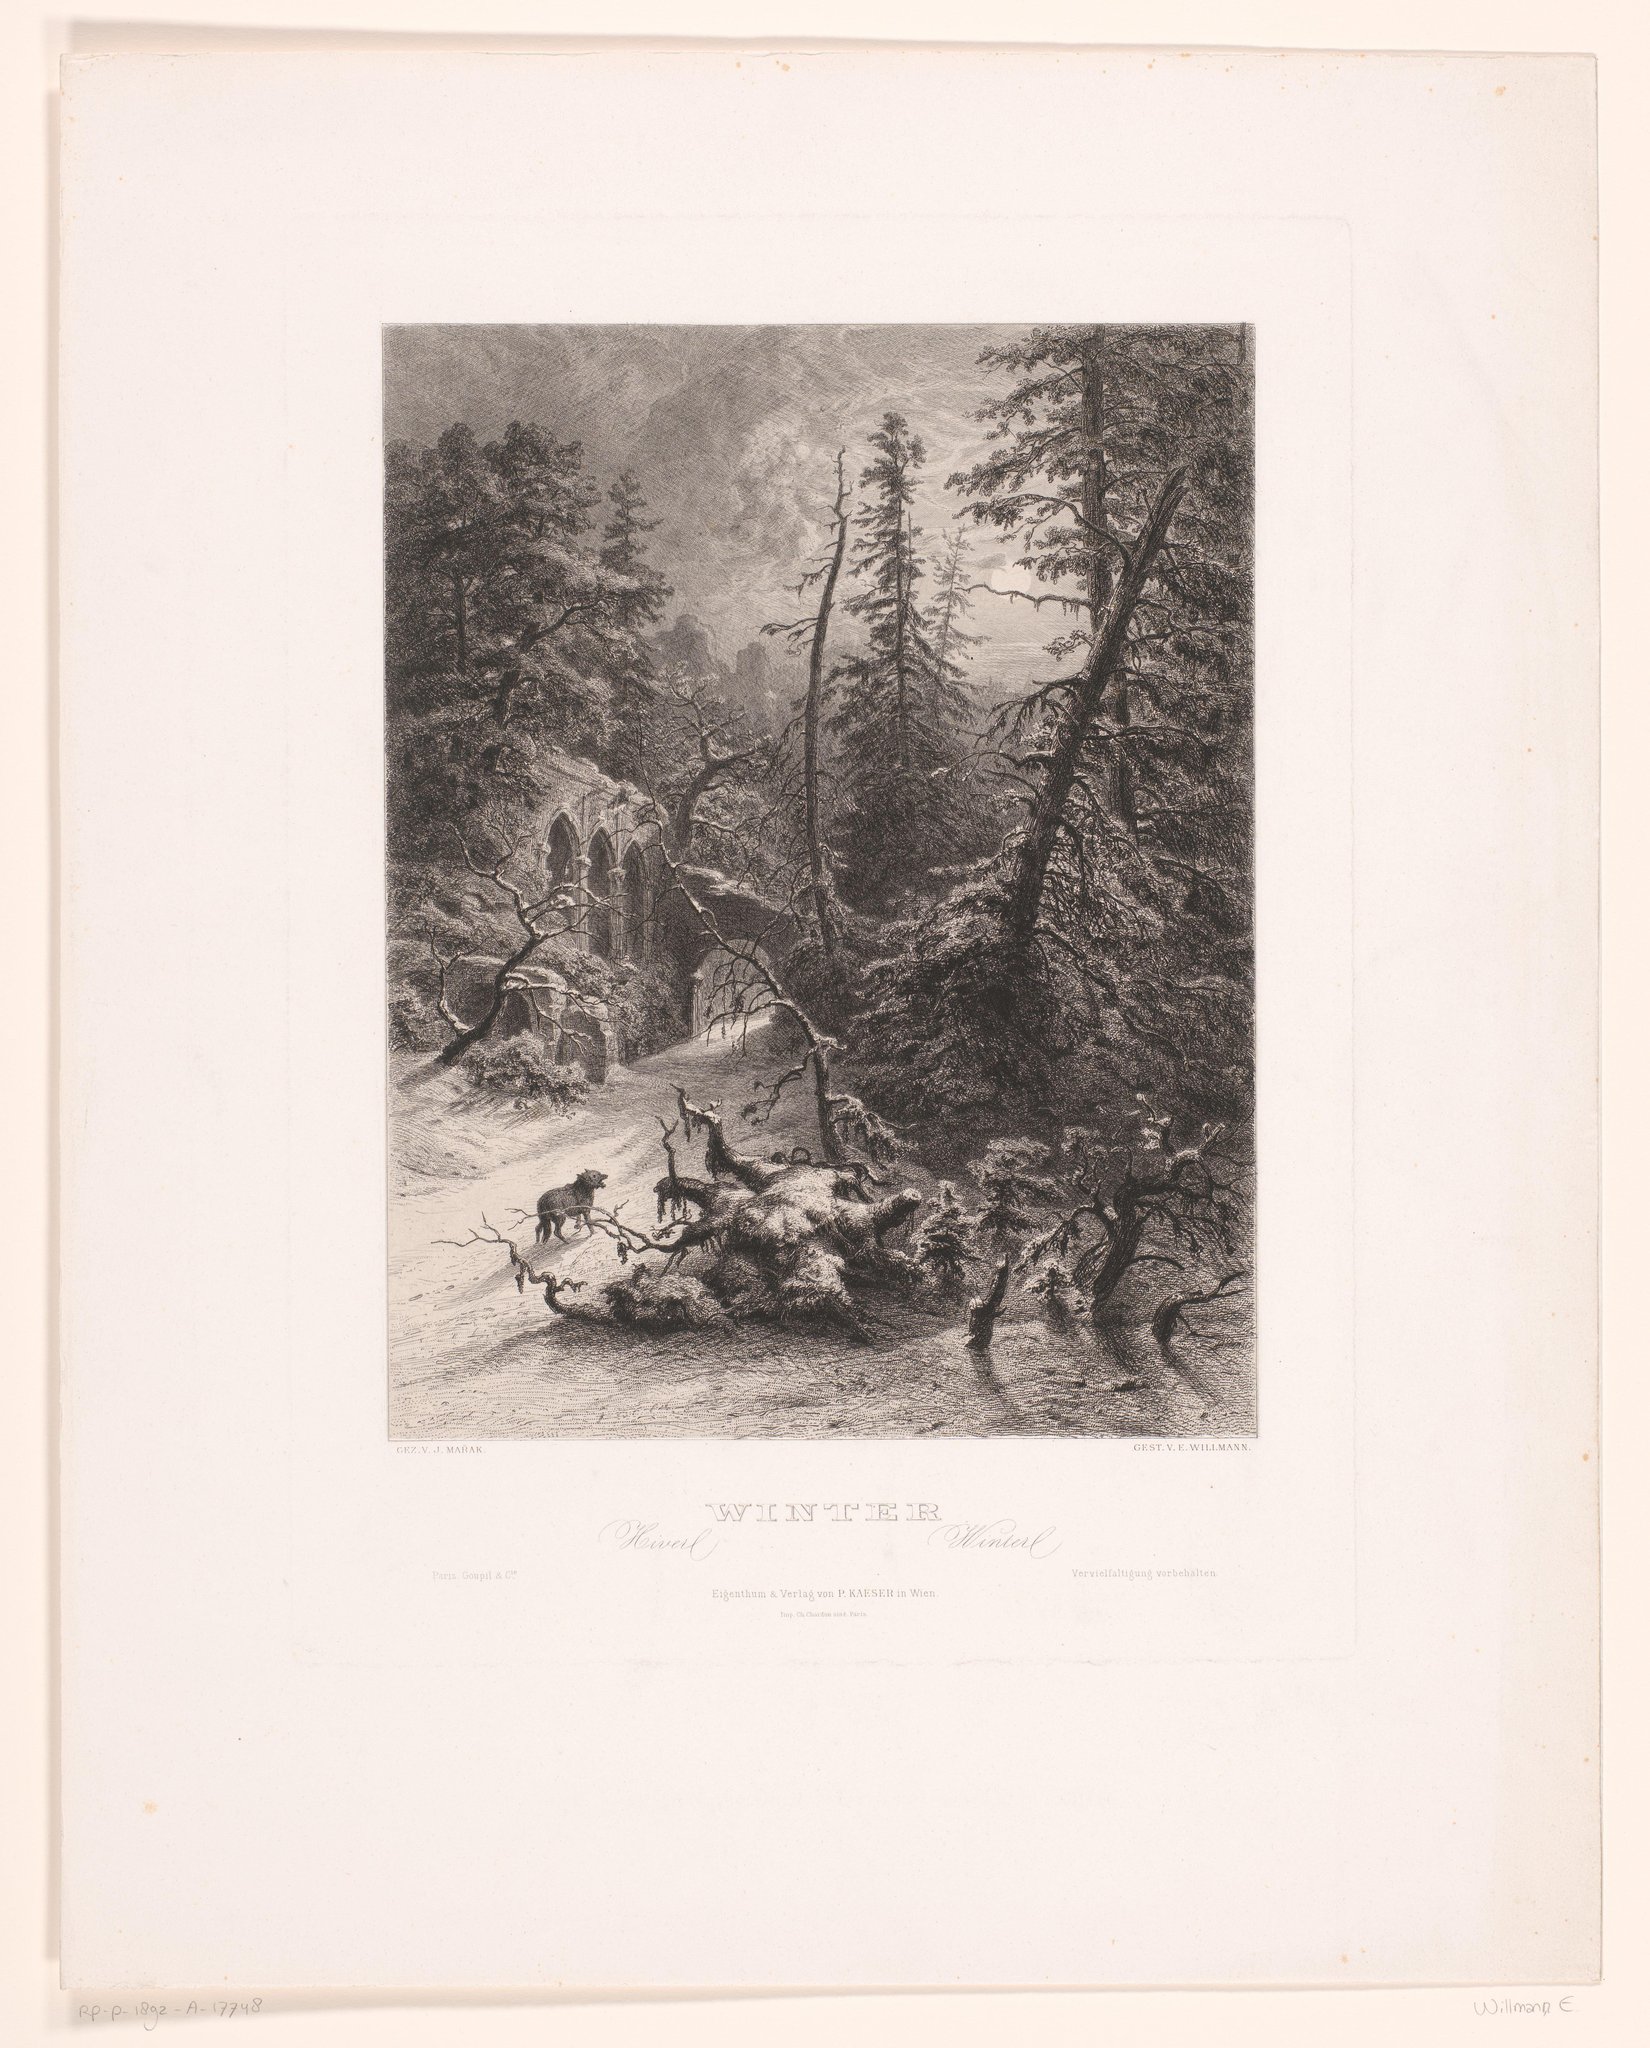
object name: print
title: De vier seizoenen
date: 1842-1877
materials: paper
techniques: etching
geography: vienna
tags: winter landscape; landscape symbolizing winter (the four seasons of the year)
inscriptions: collector's mark: Lugt 2228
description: Prent maakt deel uit van een serie van vier seizoenen.